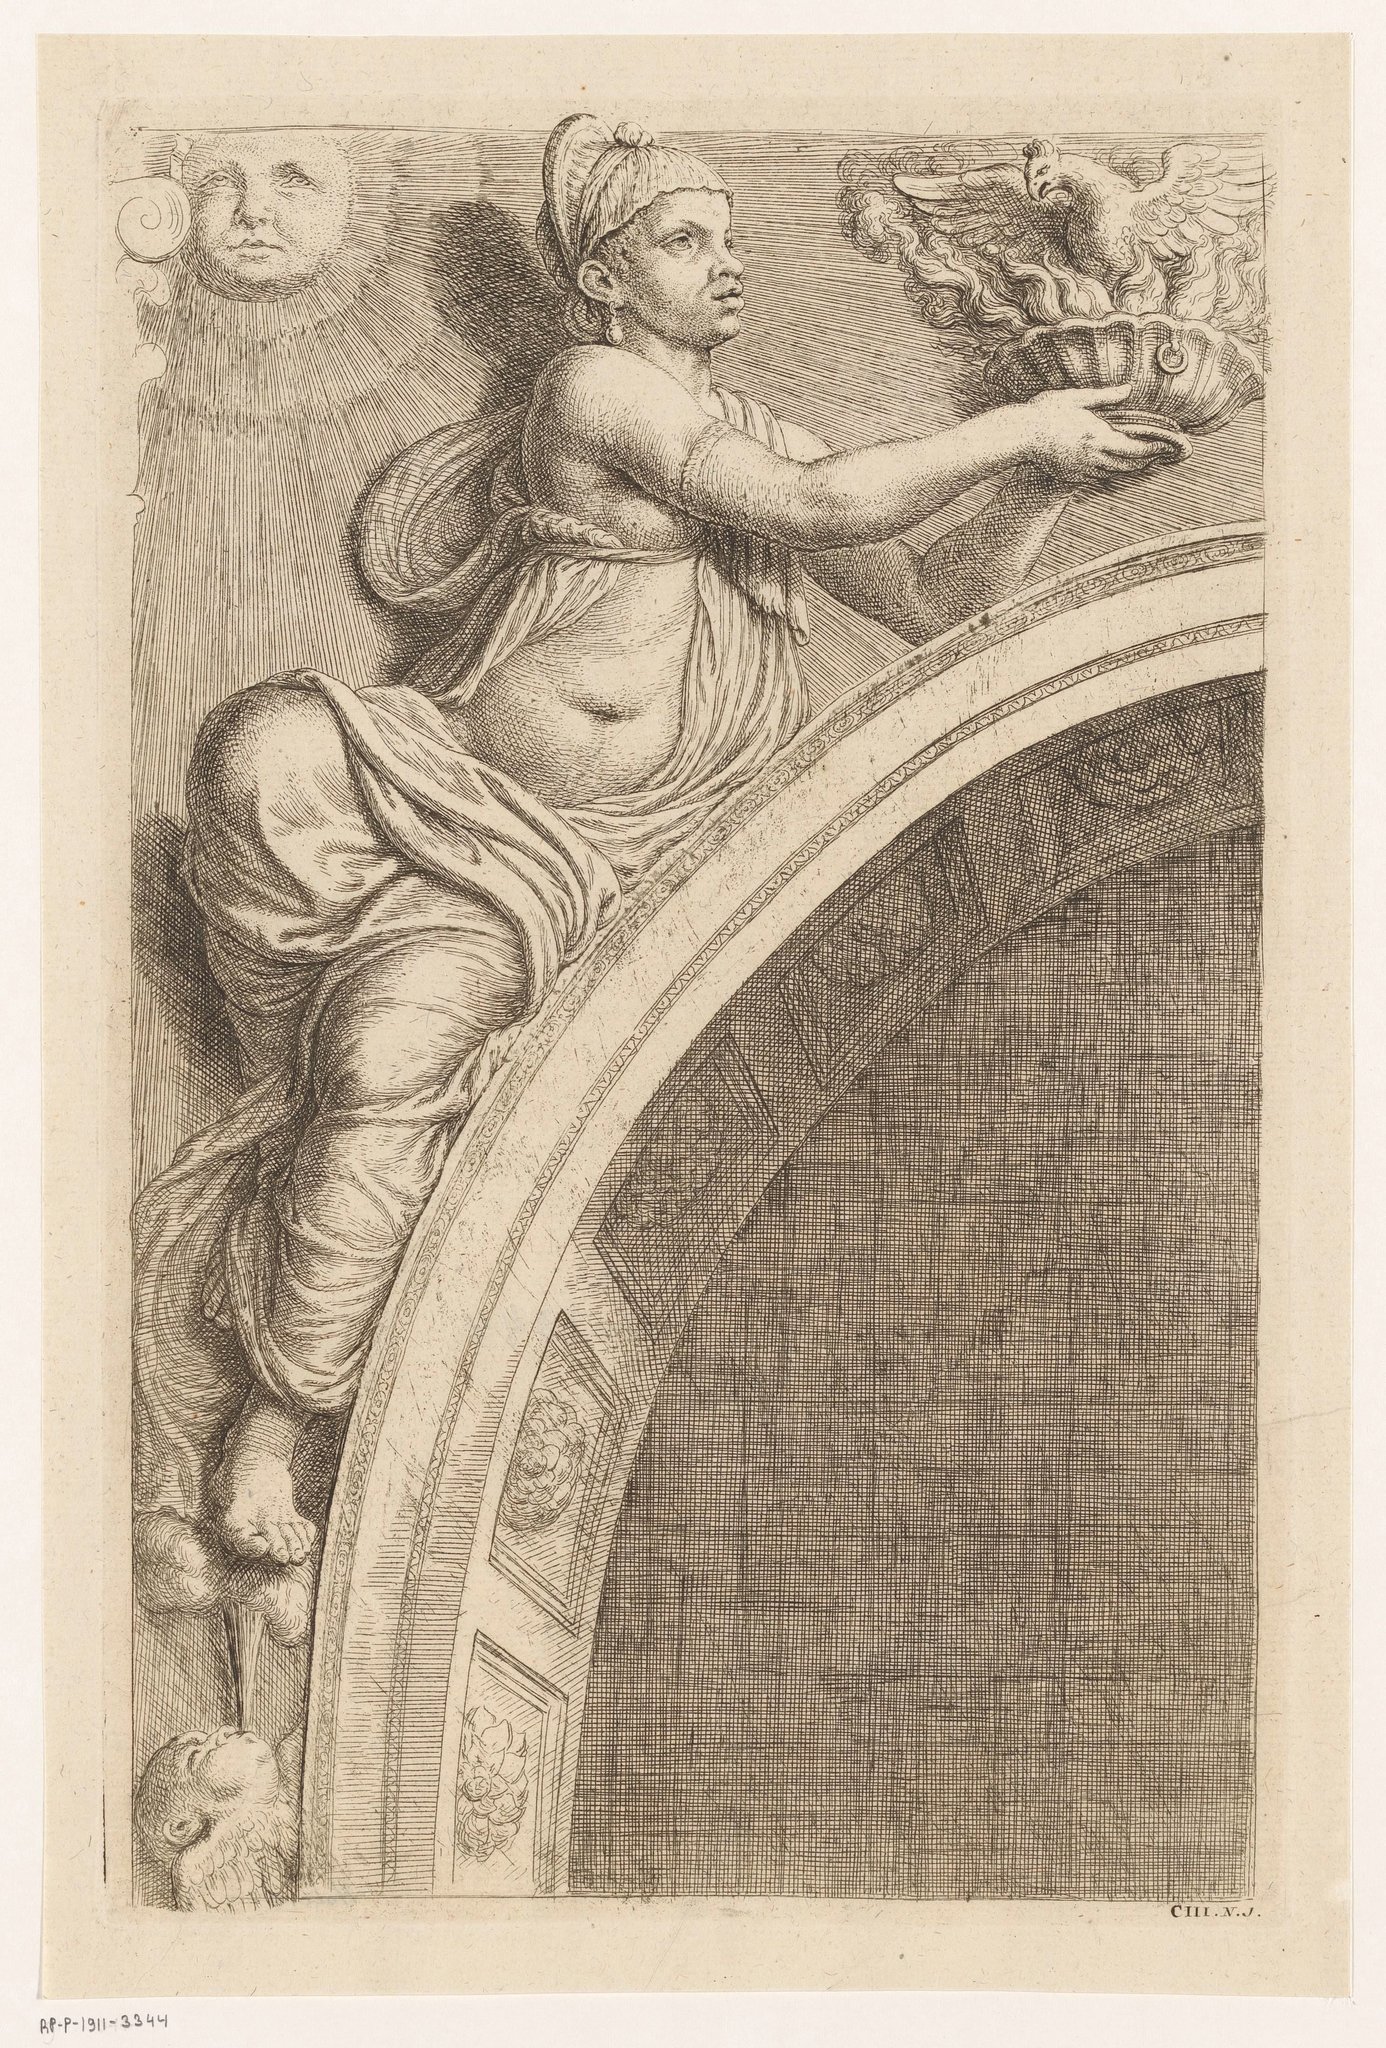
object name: book illustration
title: Reliëf met personificatie van het element Vuur boven boog aan westzijde van de Burgerzaal in het Stadhuis op de Dam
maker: hubert quellinus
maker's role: print maker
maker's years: 1619-1687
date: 1663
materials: paper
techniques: engraving, etching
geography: amsterdam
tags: fire (one of the four elements), sun represented as face, wheel, etc., cupids: 'amores', 'amoretti', 'putti', fabulous animals ~ birds: phoenix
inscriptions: collector's mark: Lugt 2228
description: Huidige staat van prent ook gebruikt in: Architecture peinture et sculpture de la Maison de Ville d'Amsterdam, representee en CIX. figures en taille-douce (…). Amsterdam: David Mortier, 1719. En in: Architecture peinture et sculpture de la Maison de Ville d'Amsterdam, representee en CIX. figures en taille-douce (…). Amsterdam: Gerard Valck, 1719. En in: Bouw schilder en beeldhouwkonst, van het Stadhuis te Amsteldam, vertoont in CIX figuuren (…). Amsterdam: Covens & Mortier & Covens Jr., s.a. (1774-1783). Eerdere staat van prent ook gebruikt in: Secunca pars Praecipuarum effigierum ac ornamentorum amplissime Curiae Amstelrodamensis maiori ex parte in cadido marmore effectorum per Artum Quellinium eiusdem Civitatis Statuarium / Het tweede deel Van de voornaemste Statuen ende Cieraten van 't konst-rijcke Stadt-huys van Amstelredam 'tmeeste in Marmer gemaeckt door Artus Quellinus Beelthouwer der voorseyde Stadt. Amsterdam: Artus Quellinus (I), 1663. En in: Secunca pars Praecipuarum effigierum ac ornamentorum amplissime Curiae Amstelrodamensis maiori ex parte in cadido marmore effectorum per Artum Quellinium eiusdem Civitatis Statuarium / Het tweede deel Van de voornaemste Statuen ende Cieraten van 't konst-rijcke Stadt-huys van Amstelredam 'tmeeste in Marmer gemaeckt door Artus Quellinus Beelthouwer der voorseyde Stadt. Amsterdam: Frederik de Wit, 1668.